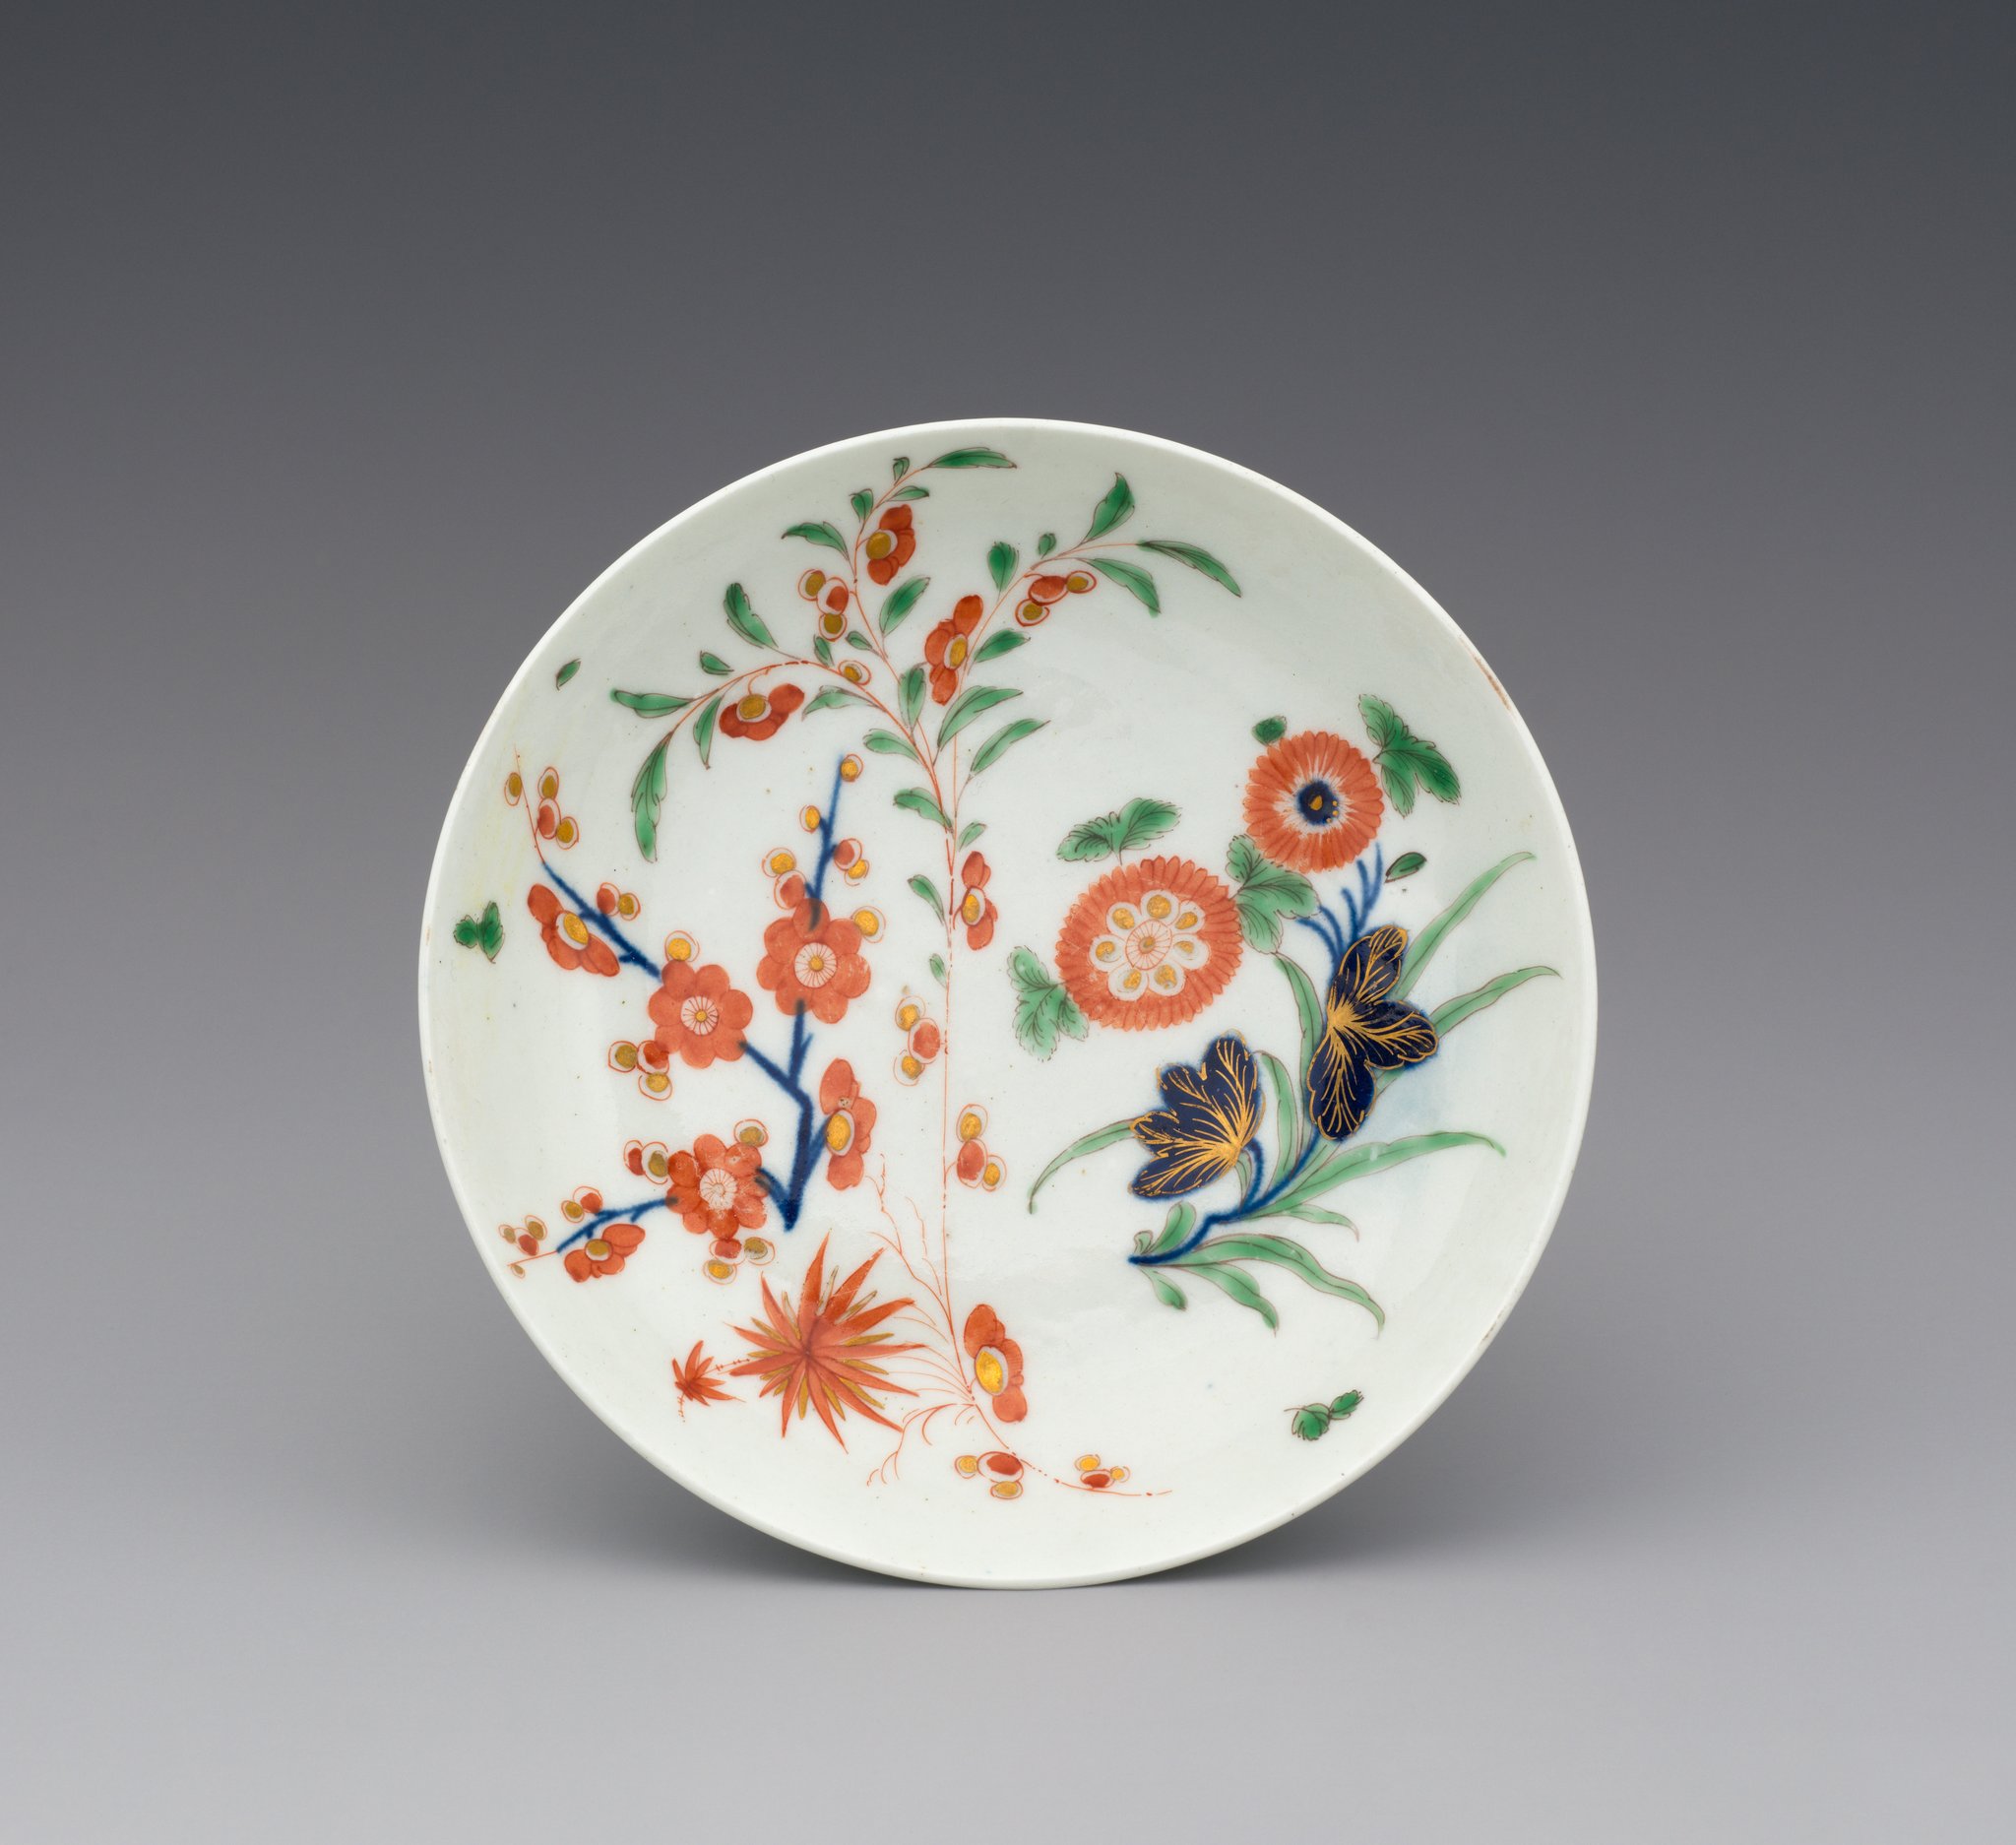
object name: saucer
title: Saucer (part of a service)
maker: worcester factory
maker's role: factory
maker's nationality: british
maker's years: 1751-2008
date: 1765-1770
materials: soft paste porcelain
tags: flowers